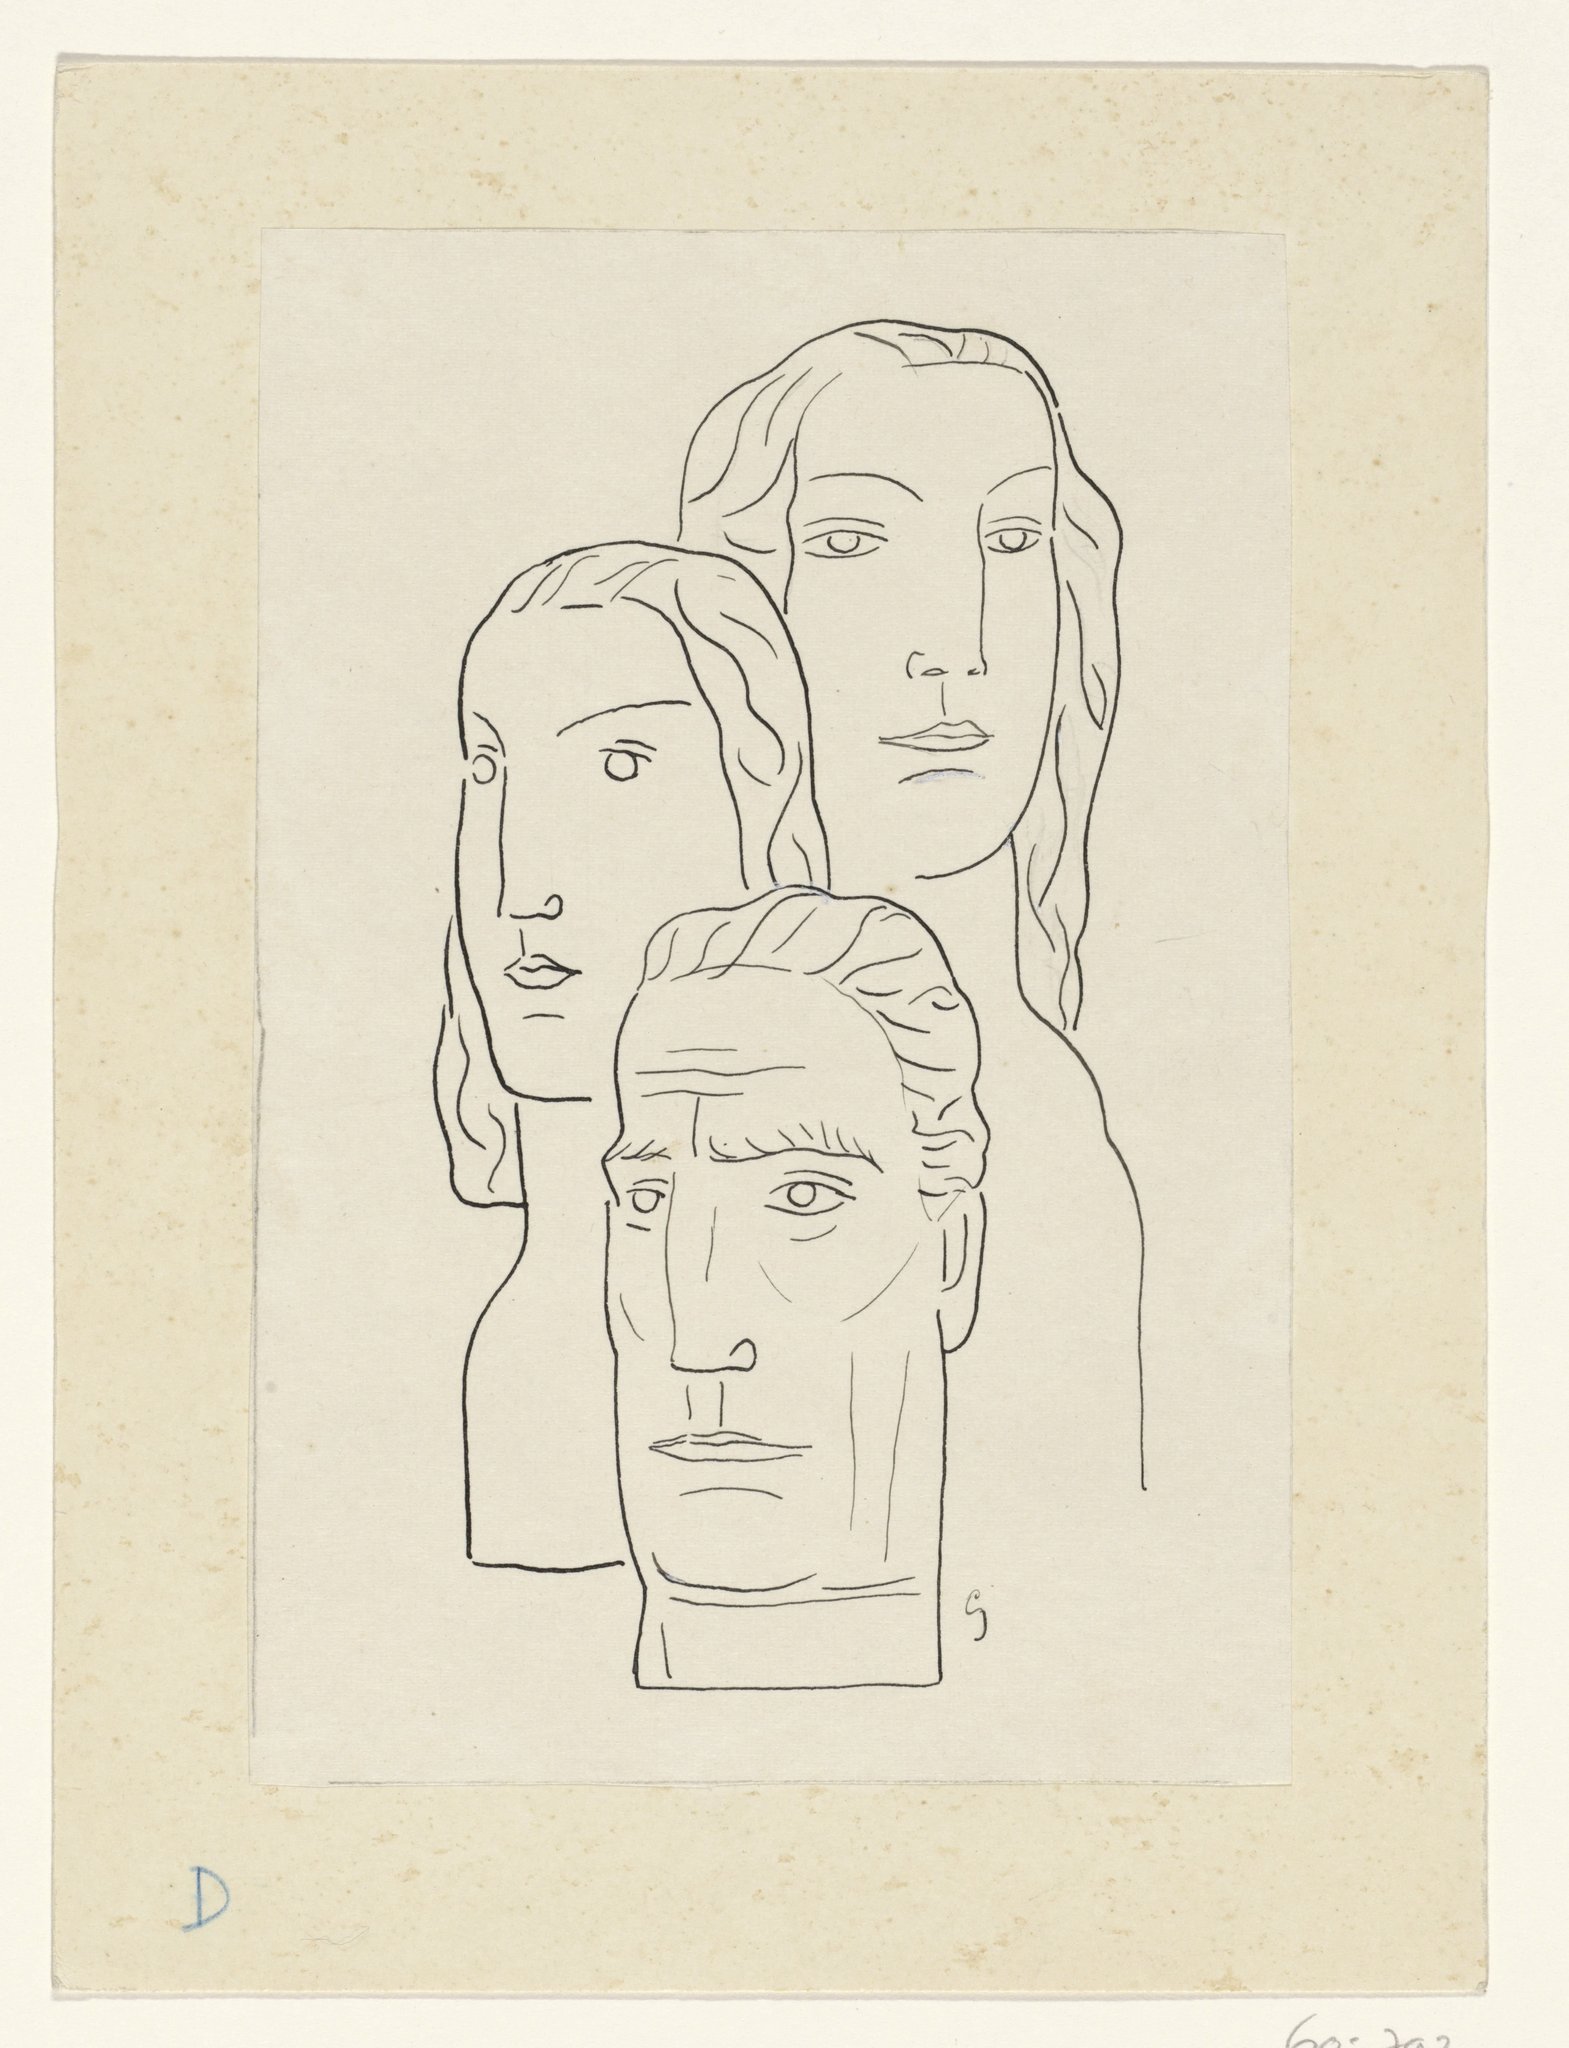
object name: design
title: Twee vrouwenhoofden en een mannenhoofd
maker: leo gestel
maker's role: draughtsman, print maker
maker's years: 1881-1941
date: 1891-1941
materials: paint, ink, paper, pencil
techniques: pen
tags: head (human), head (human) - aa - female human figure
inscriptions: collector's mark: Lugt 2228, :